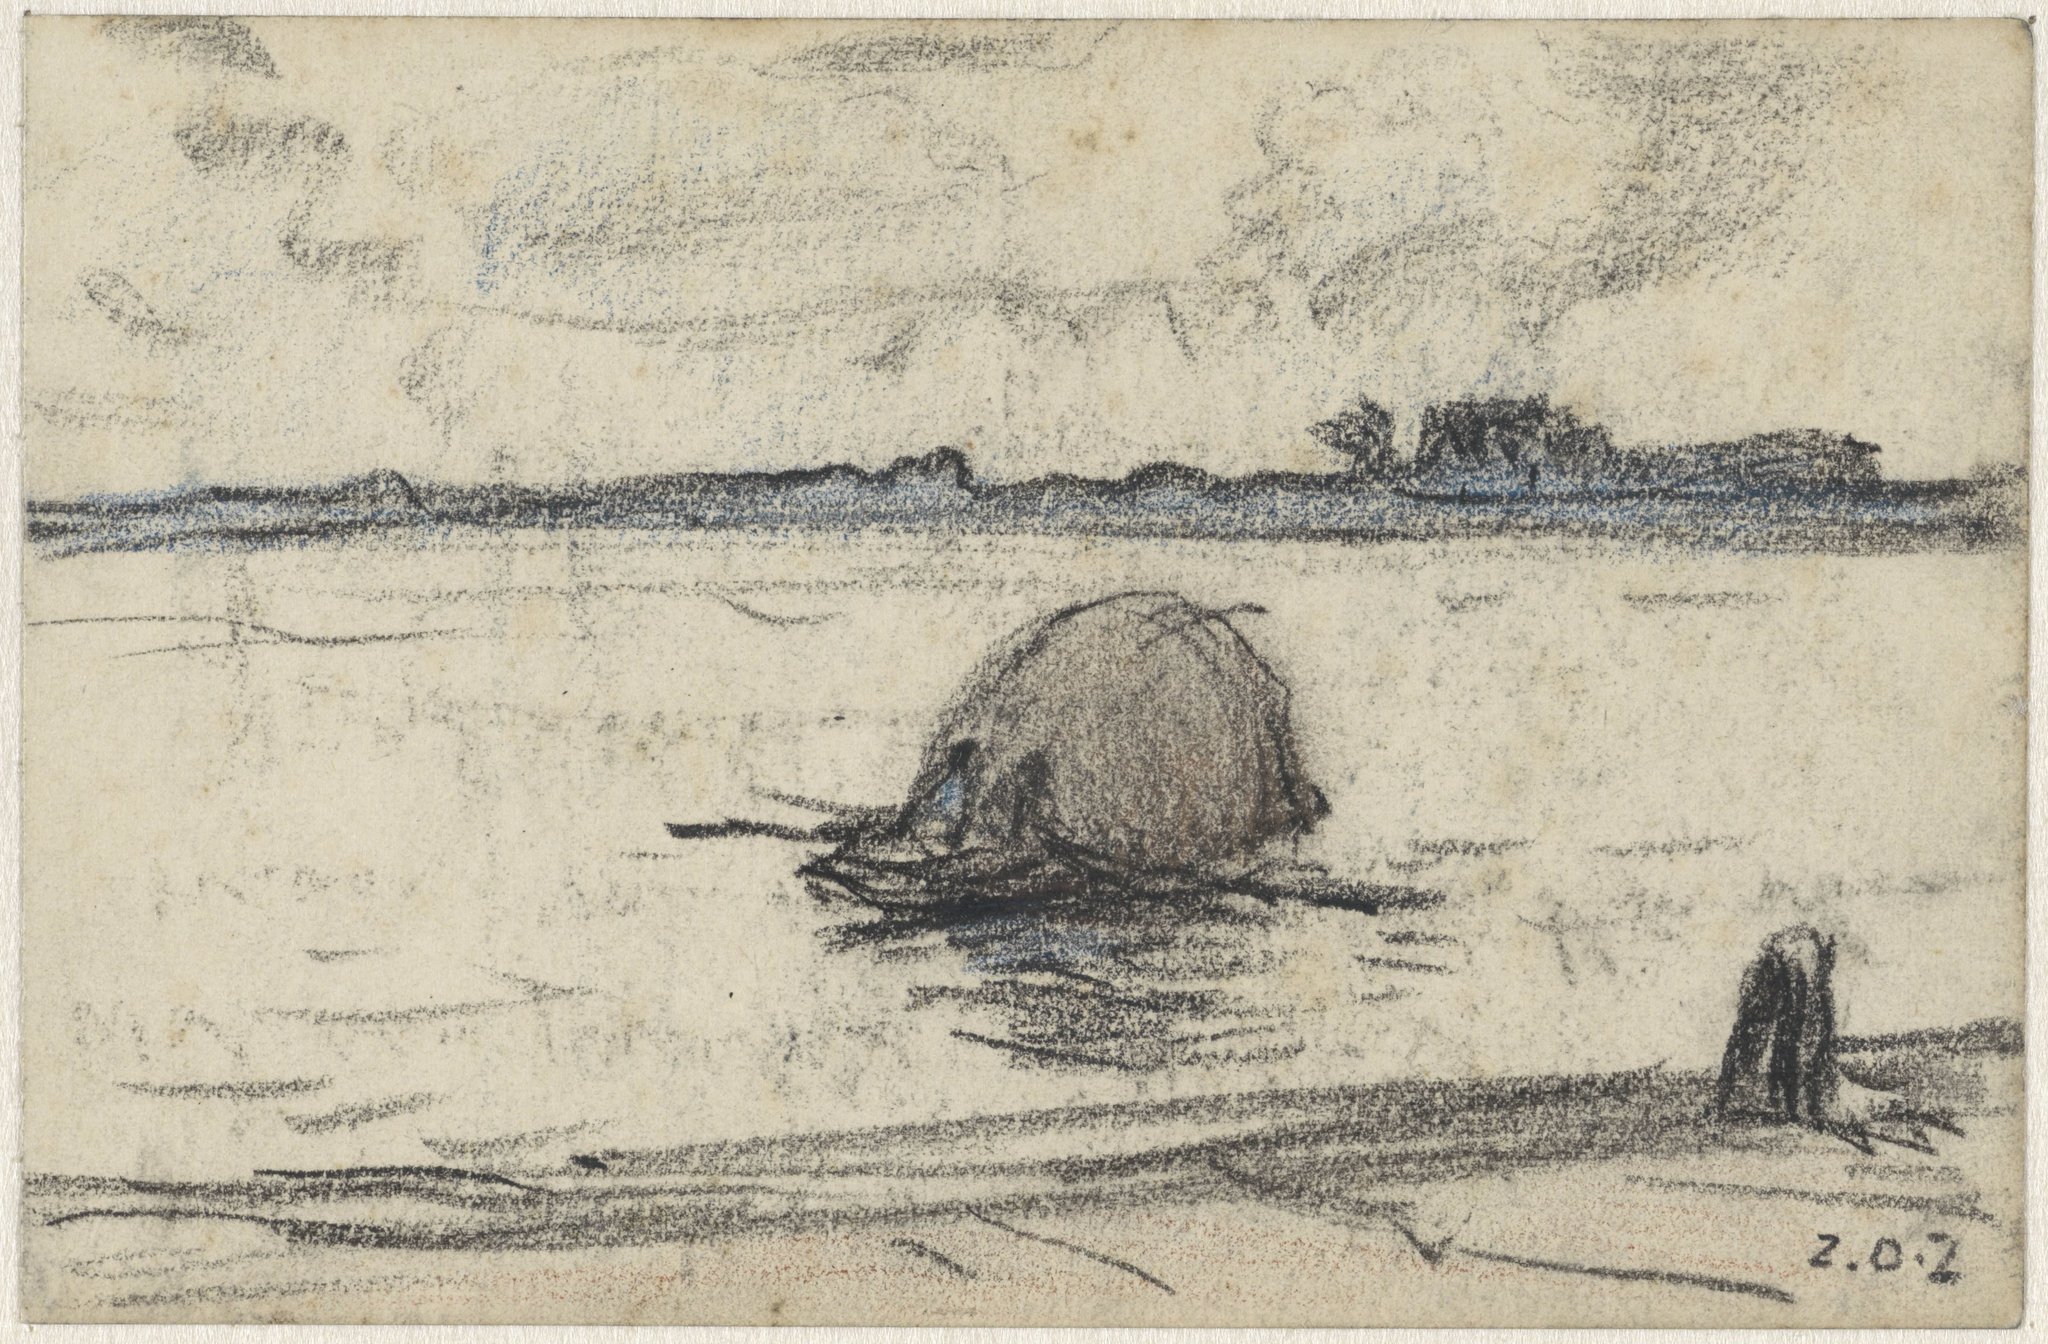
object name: drawing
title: Schuit met hooi op een rivier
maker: adolf le comte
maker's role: draughtsman, painter, print maker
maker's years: 1850-1921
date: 1860-1921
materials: chalk, paper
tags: rowing-boat, canoe, etc., transporting ~ harvest